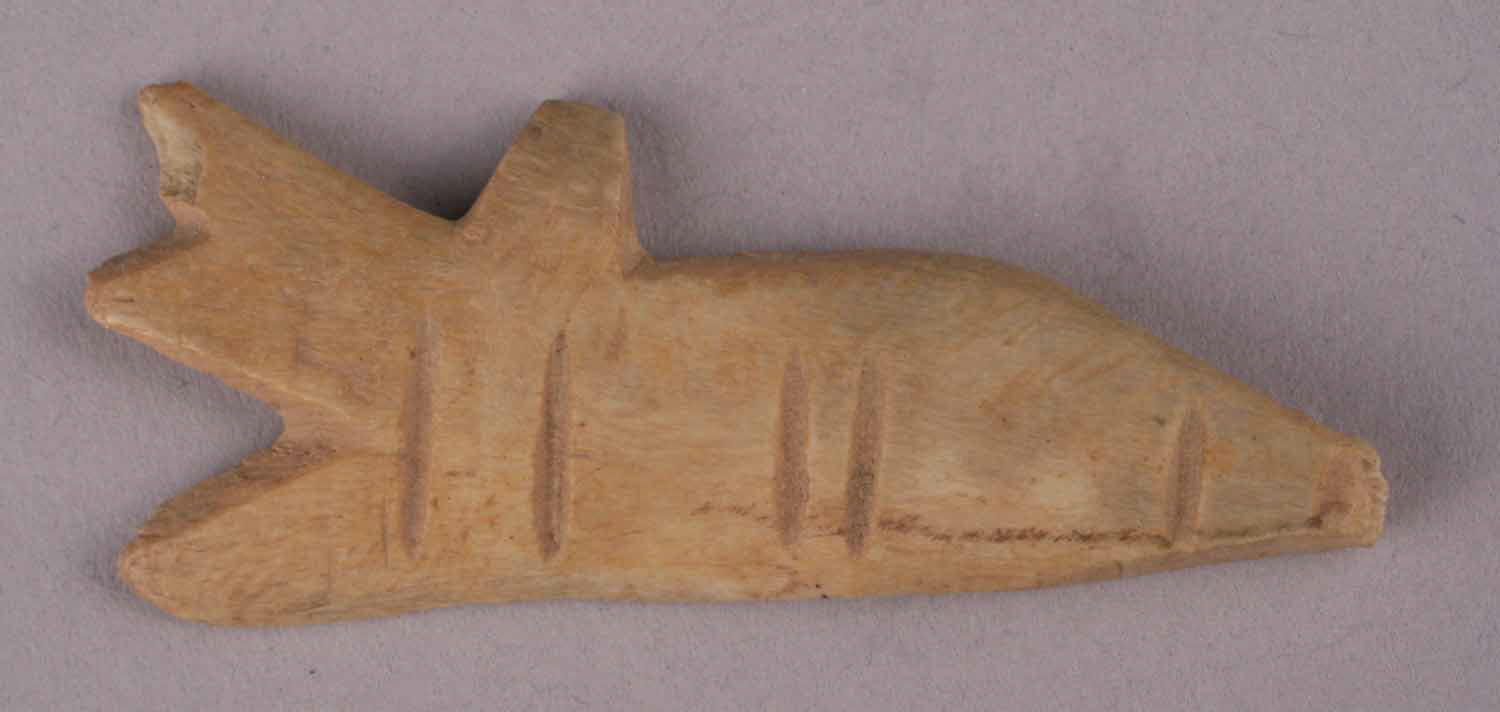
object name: gaming piece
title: Gaming Piece Possibly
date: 801-1000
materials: bone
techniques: carving, incising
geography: iran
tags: games